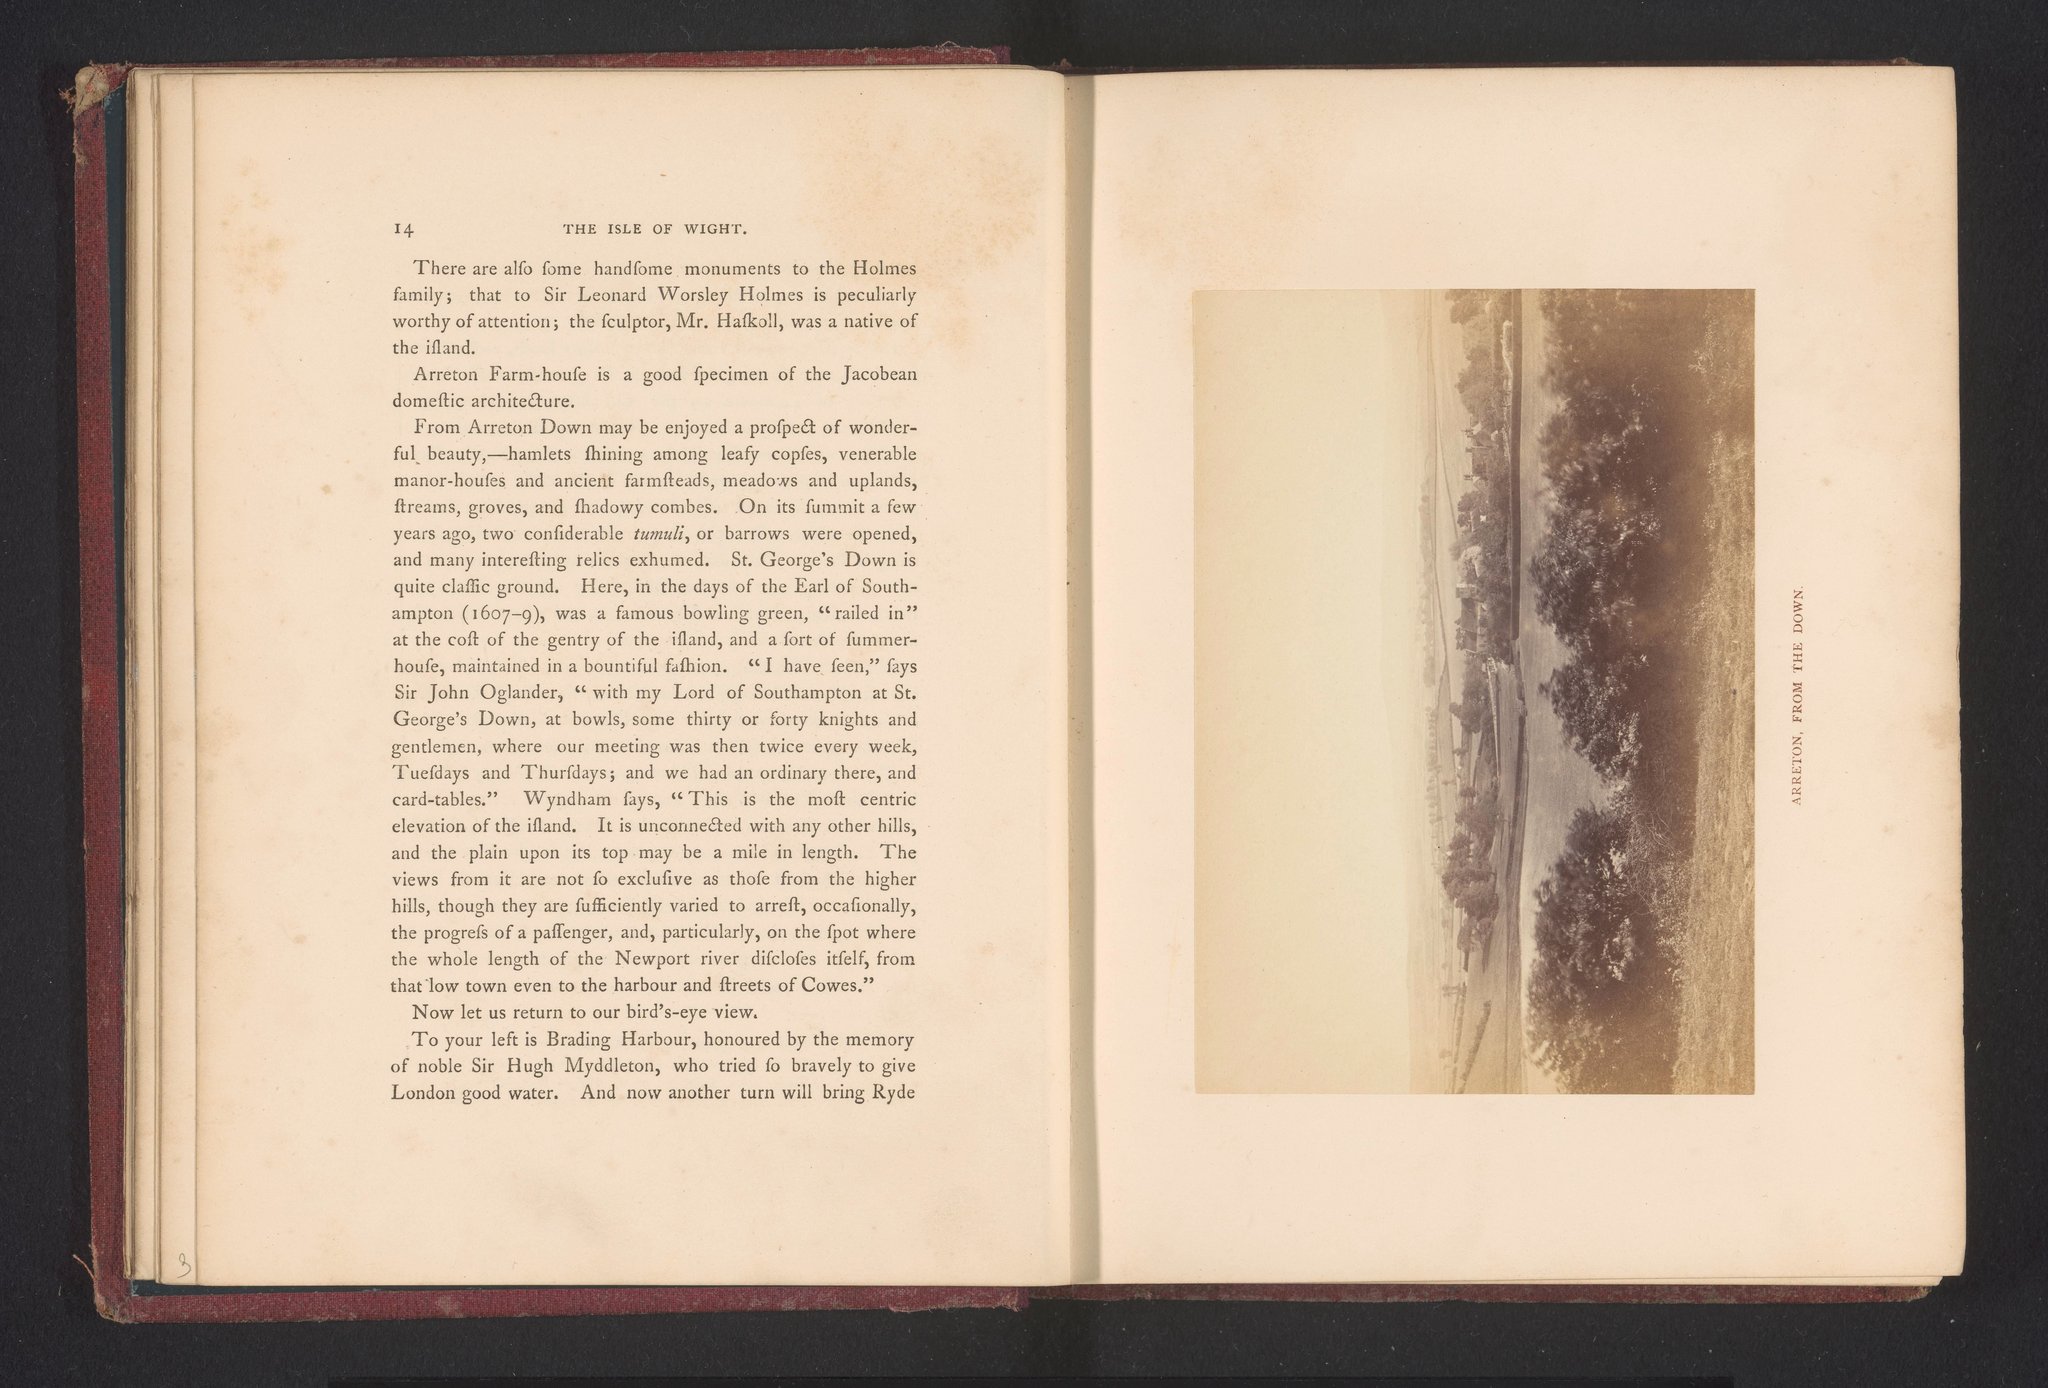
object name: photograph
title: Arreton, from the Down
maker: william russell sedgfield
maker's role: fotograaf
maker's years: 1826-1902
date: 1859-1869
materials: photographic support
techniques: albumen print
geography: isle of wight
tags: dale, valley, city-view in general; 'veduta'